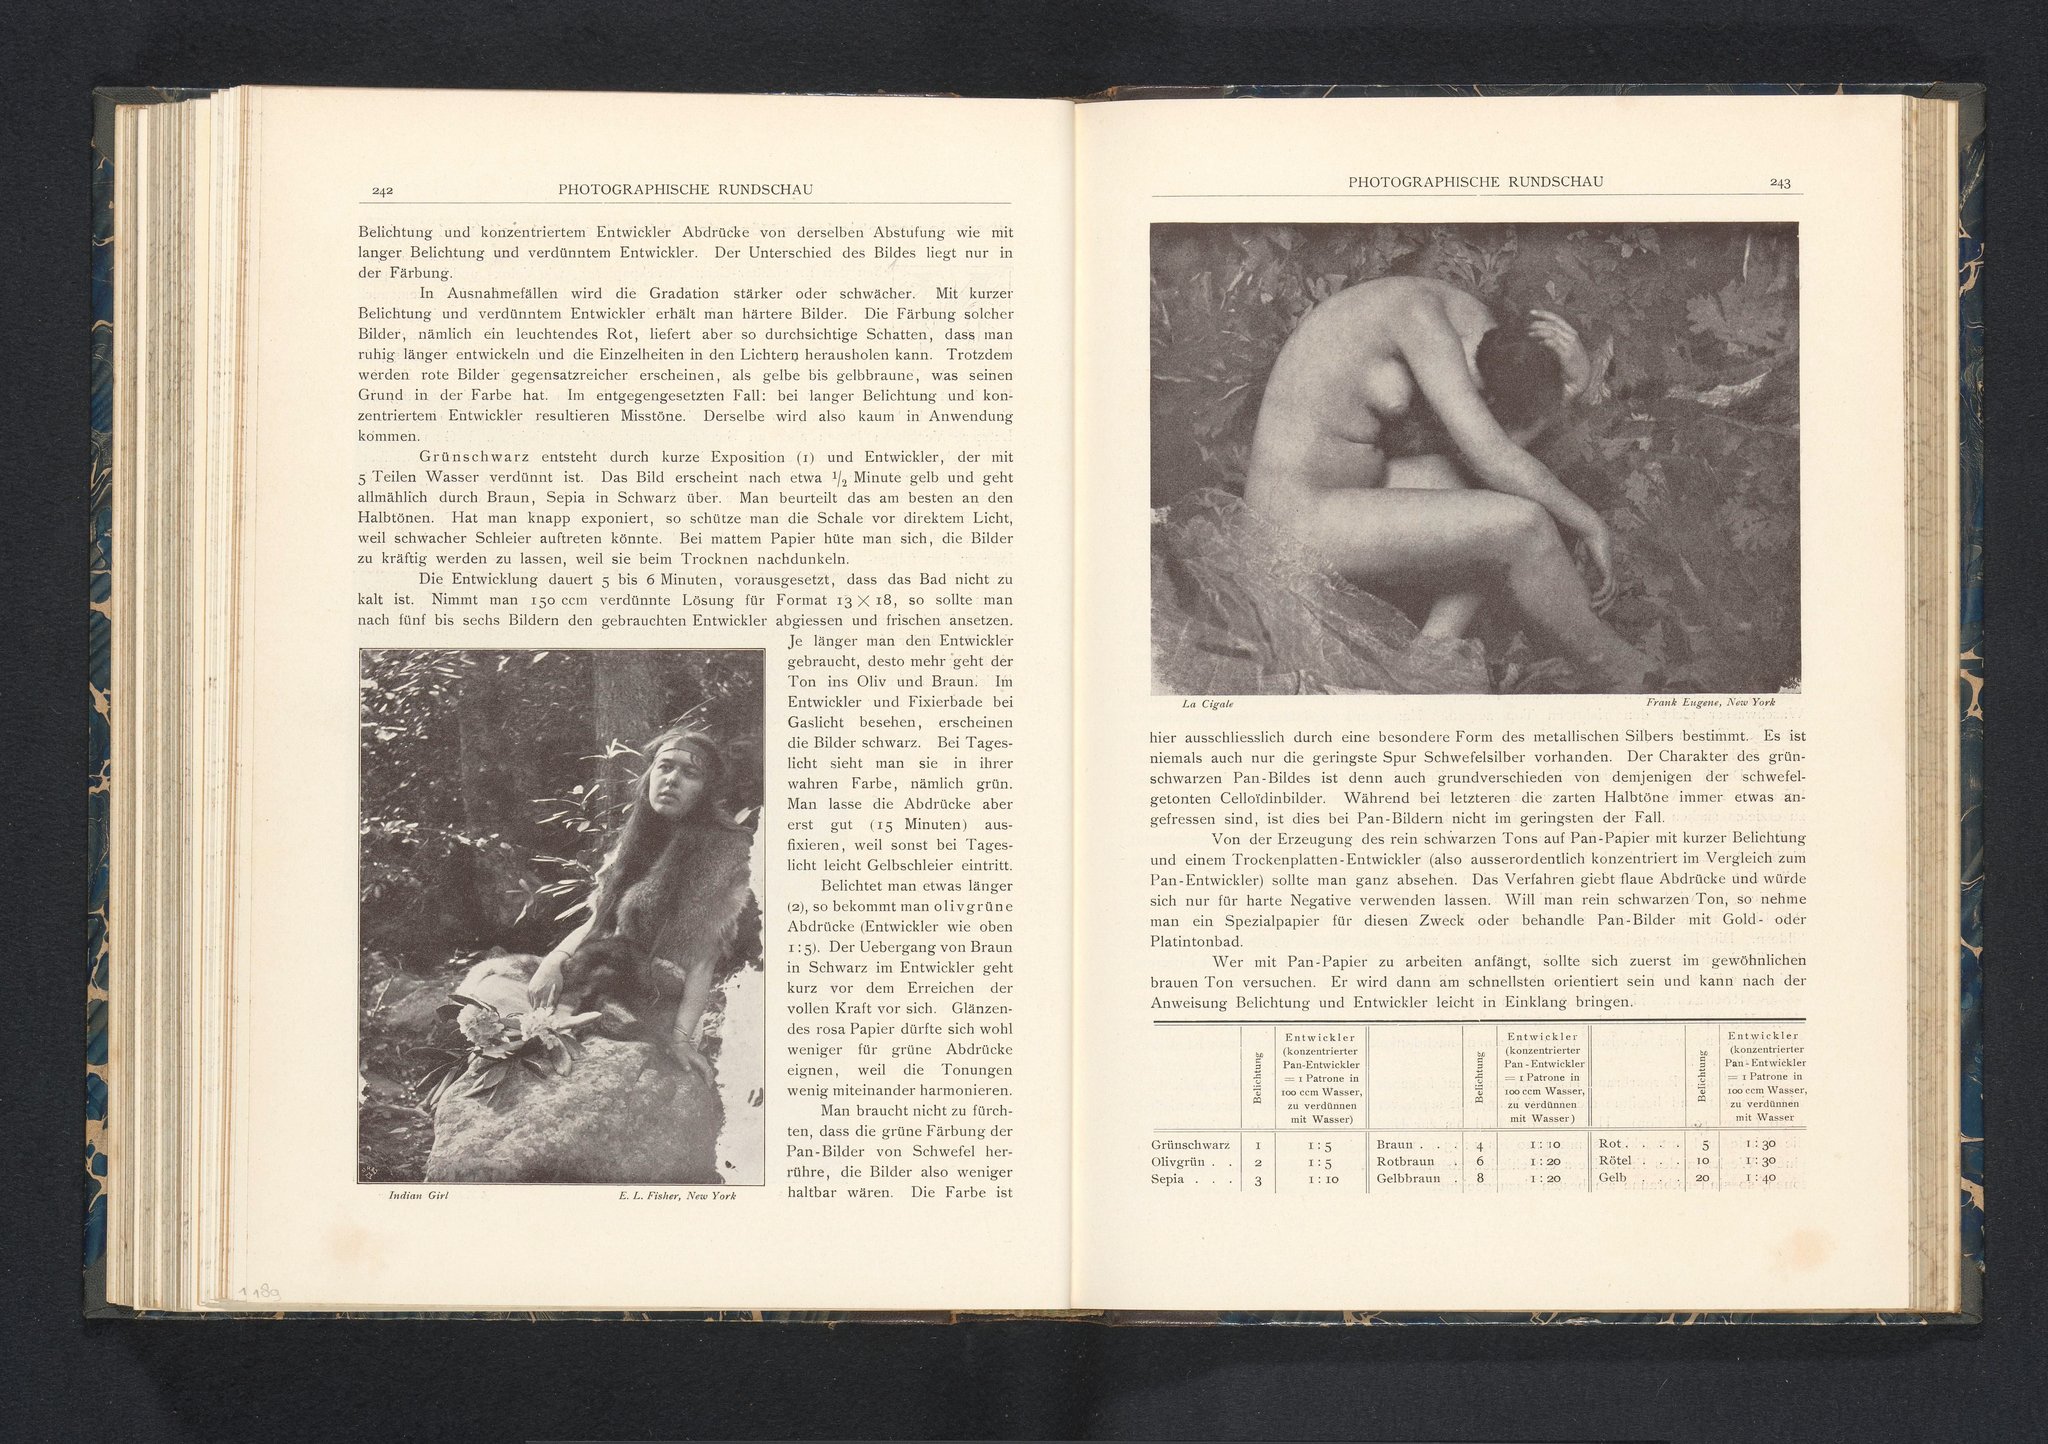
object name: photomechanical print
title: Portret van een onbekende naakte vrouw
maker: frank eugene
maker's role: fotograaf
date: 1896-1901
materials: paper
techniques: autotype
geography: berlin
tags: historical persons not known by name - bb - woman